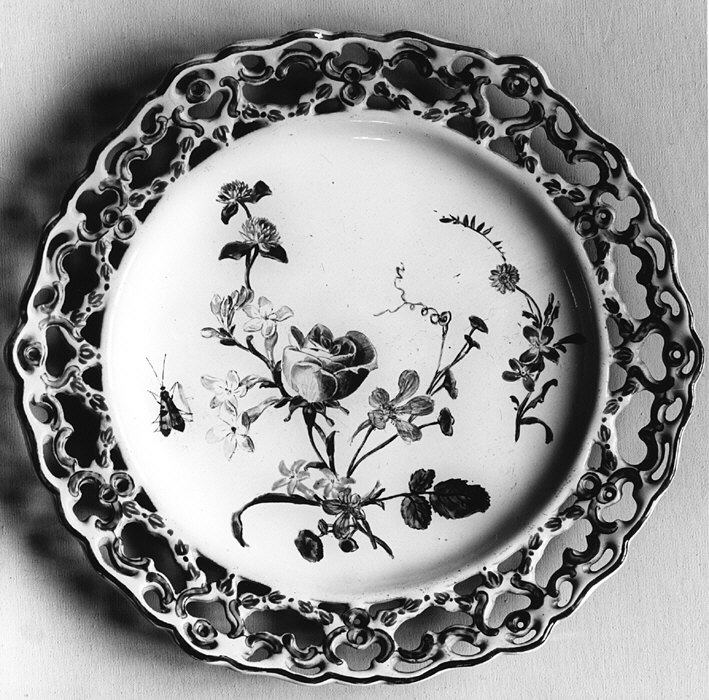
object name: plate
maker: veuve perrin factory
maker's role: factory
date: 1750-1770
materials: faience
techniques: glazing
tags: insects,roses